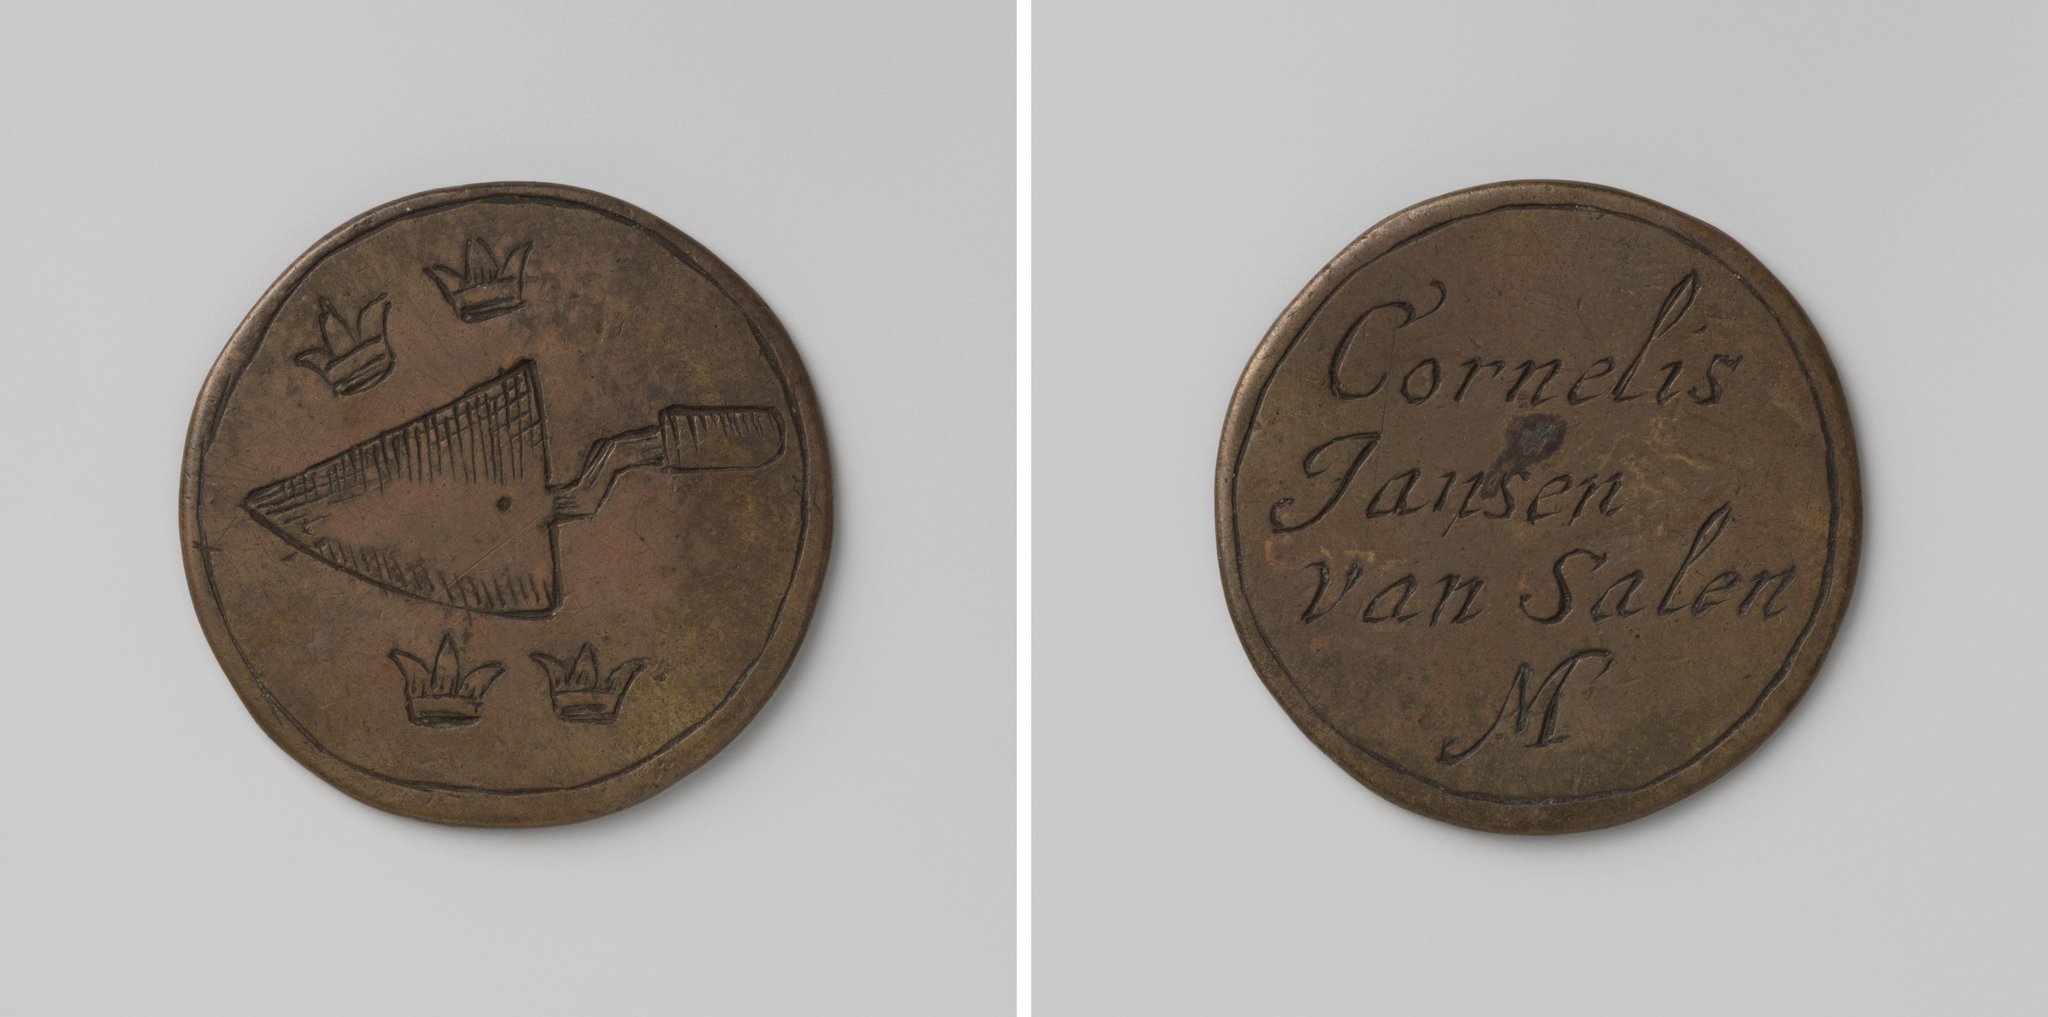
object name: medal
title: Metselaars-, steenhouwers-, leidekkers-, loodgieters- en pompenmakersgilde van Amsterdam, gildepenning van Cornelis Jansen van Salen, metselaar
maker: Anonymous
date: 1626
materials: brass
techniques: engraving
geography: amsterdam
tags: amsterdam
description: Messing penning. Voorzijde: liggende troffel tussen vier kronen. Keerzijde: opschrift